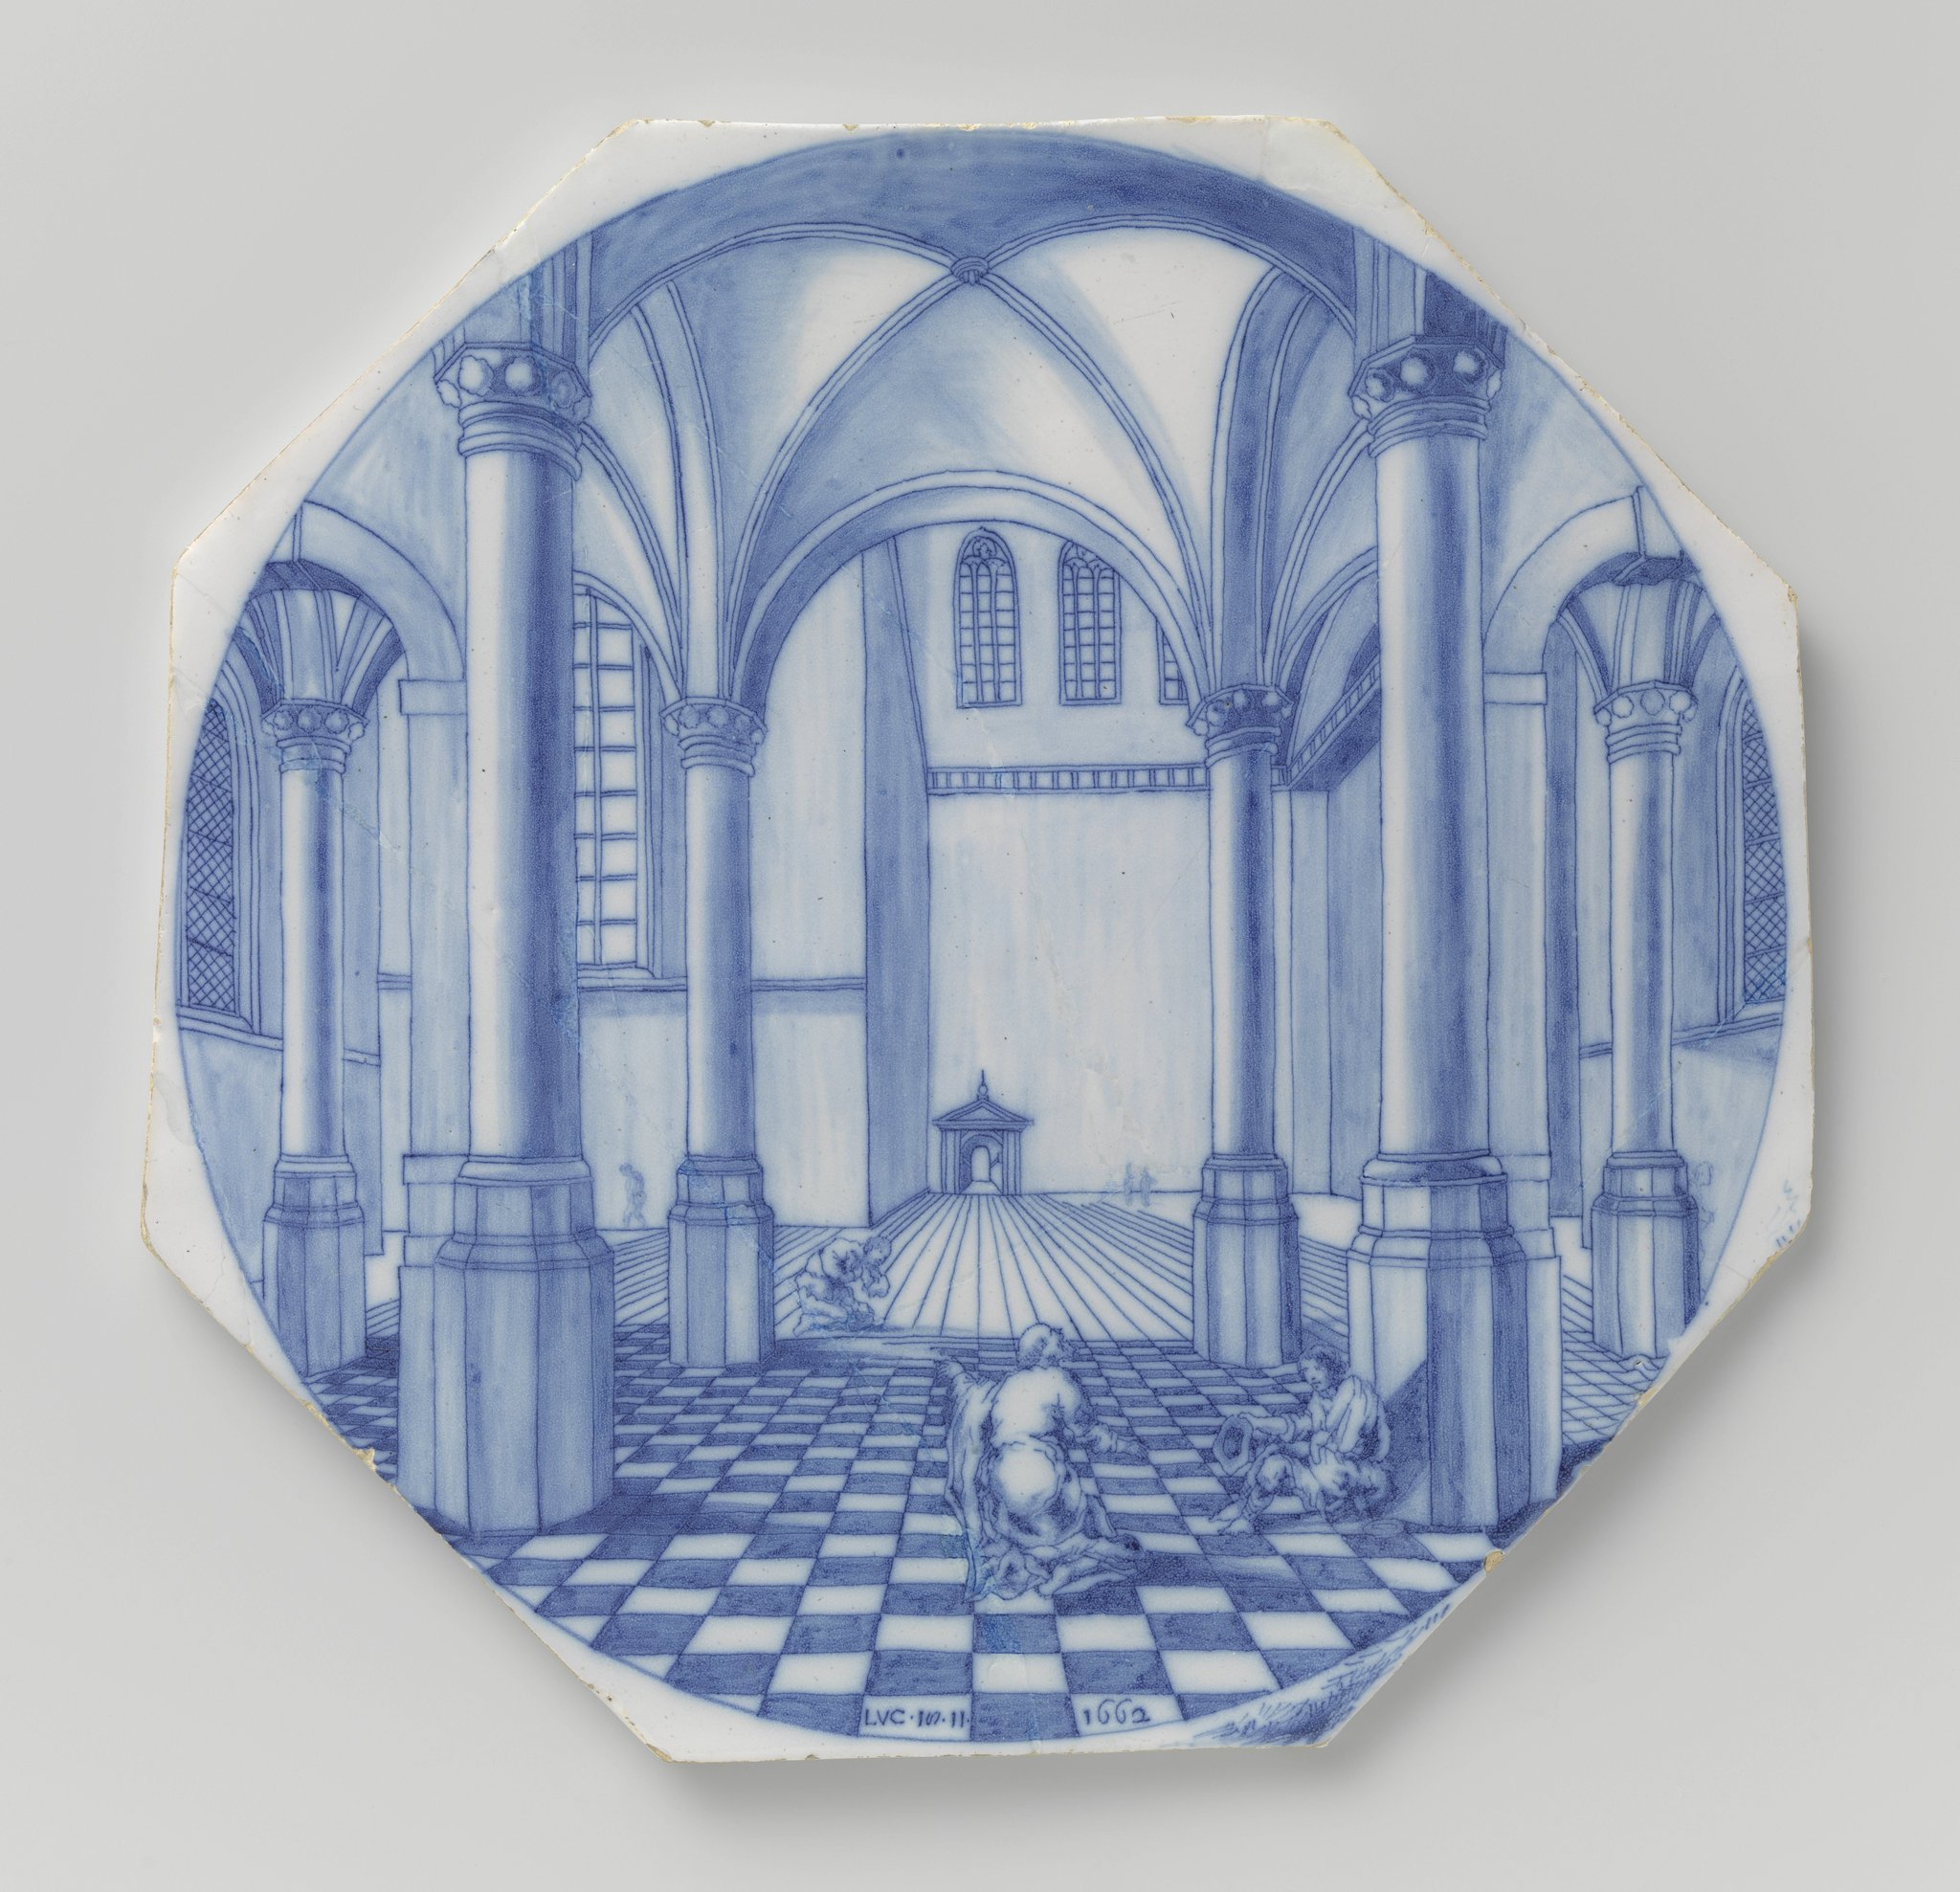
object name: plate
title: The Pharisee and the Tax Collector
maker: Anonymous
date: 1662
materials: earthenware, glaze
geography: delft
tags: the praying pharisee and the repentant publican in the temple (luke 18:10-14)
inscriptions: date: ‘1662’, inscription: ‘LVC.18.11’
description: Plaat van faïence, in blauw beschilderd met een scene uit het Nieuwe Testament: de Farizeeër en de tollenaar. Gedateerd 1662